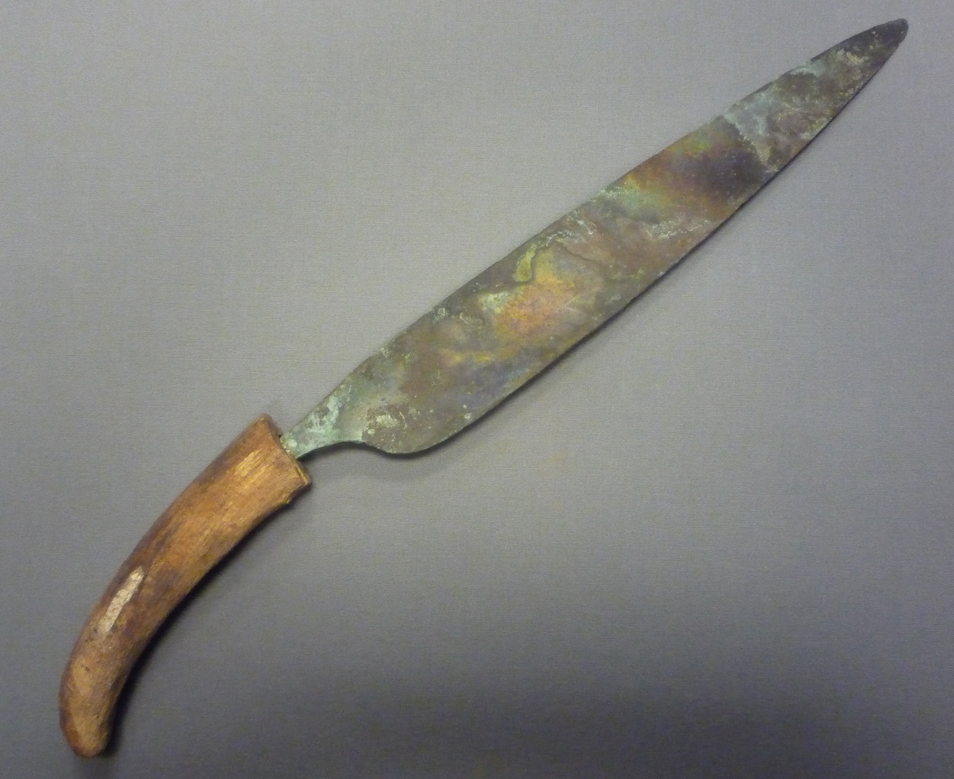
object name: saw, carpenter, hatshepsut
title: Saw From a Foundation Deposit, Hatshepsut's Temple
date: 1479-1458 BCE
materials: bronze, copper alloy, wood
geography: egypt